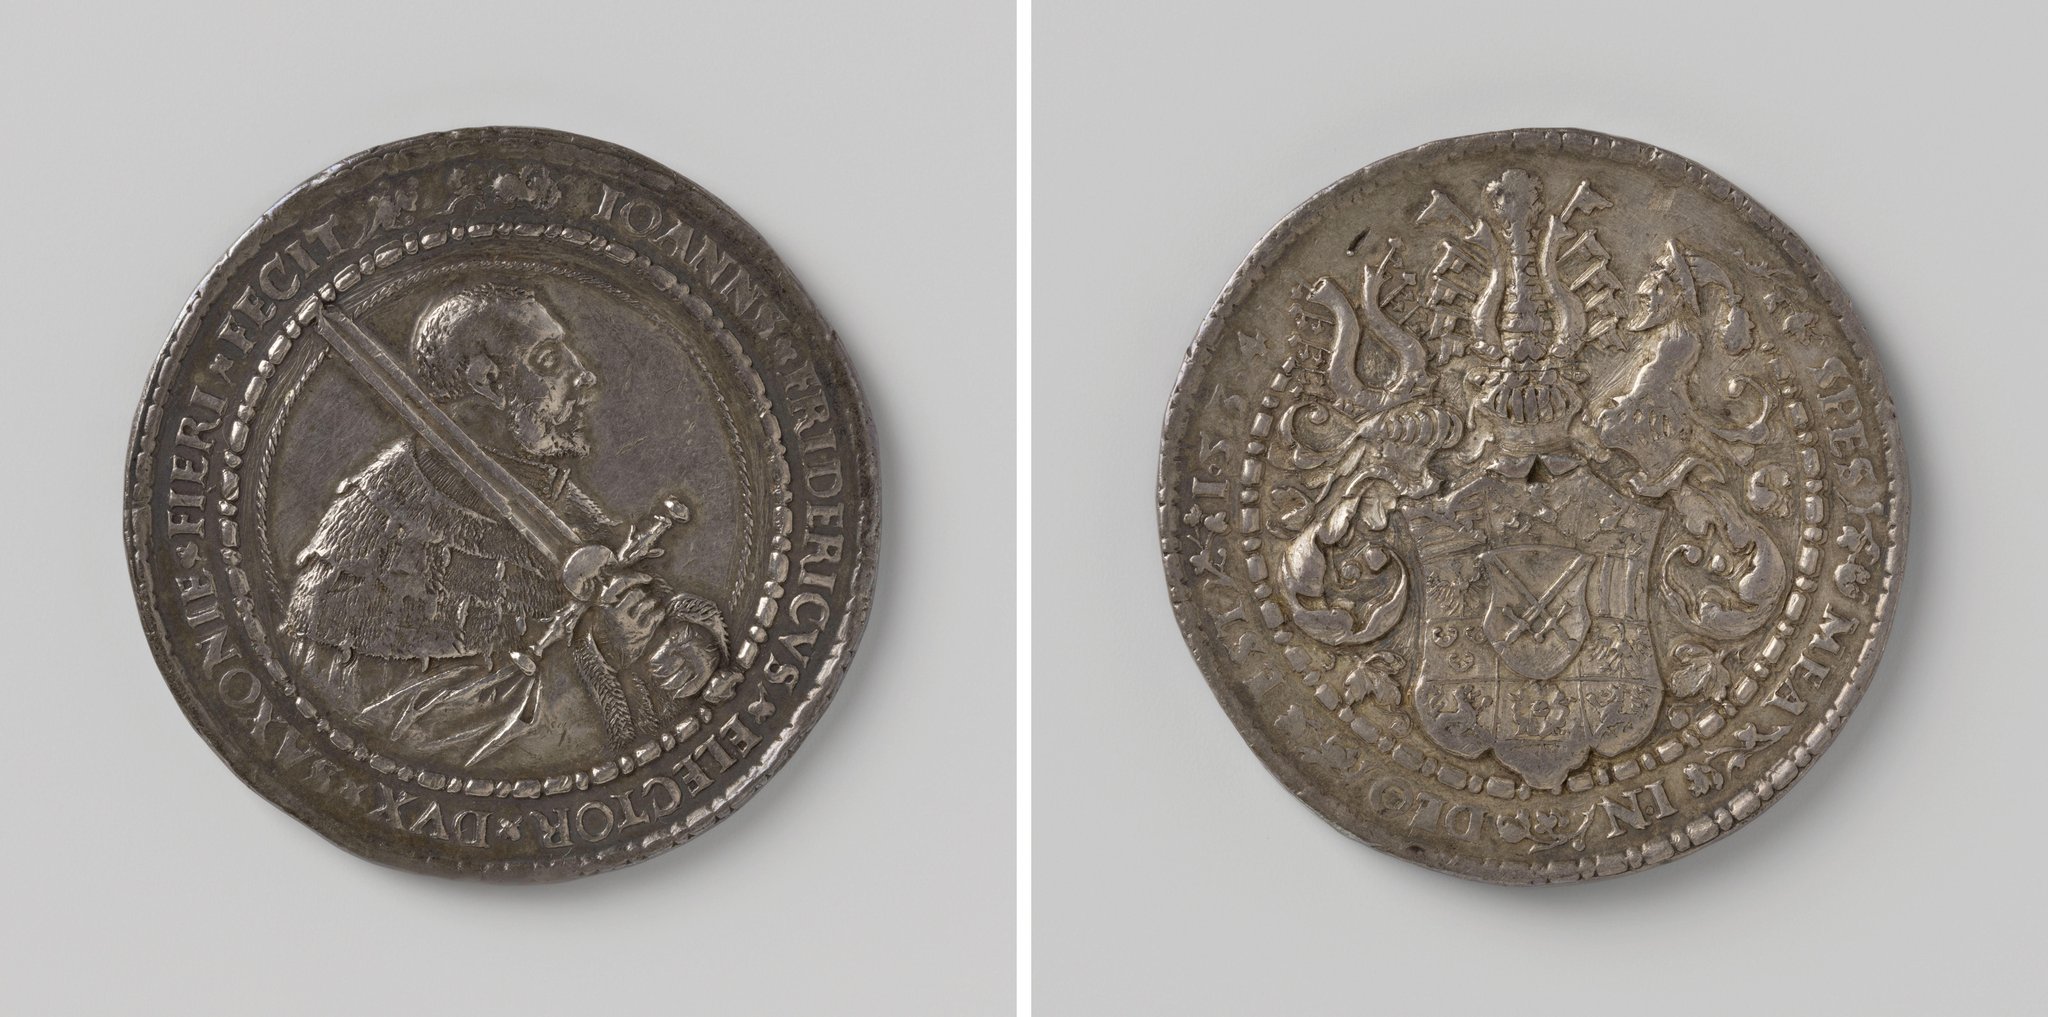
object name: history medal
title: Johan Frederik de Grootmoedige, keurvorst van Saksen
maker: Anonymous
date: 1534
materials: silver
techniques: striking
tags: weimar, keurvorst, johan frederik i (keurvorst van saksen)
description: Zilveren penning. Voorzijde: borststuk man met zwaard binnen omschrift. Keerzijde: wapenschild met drie helmen binnen omschrift